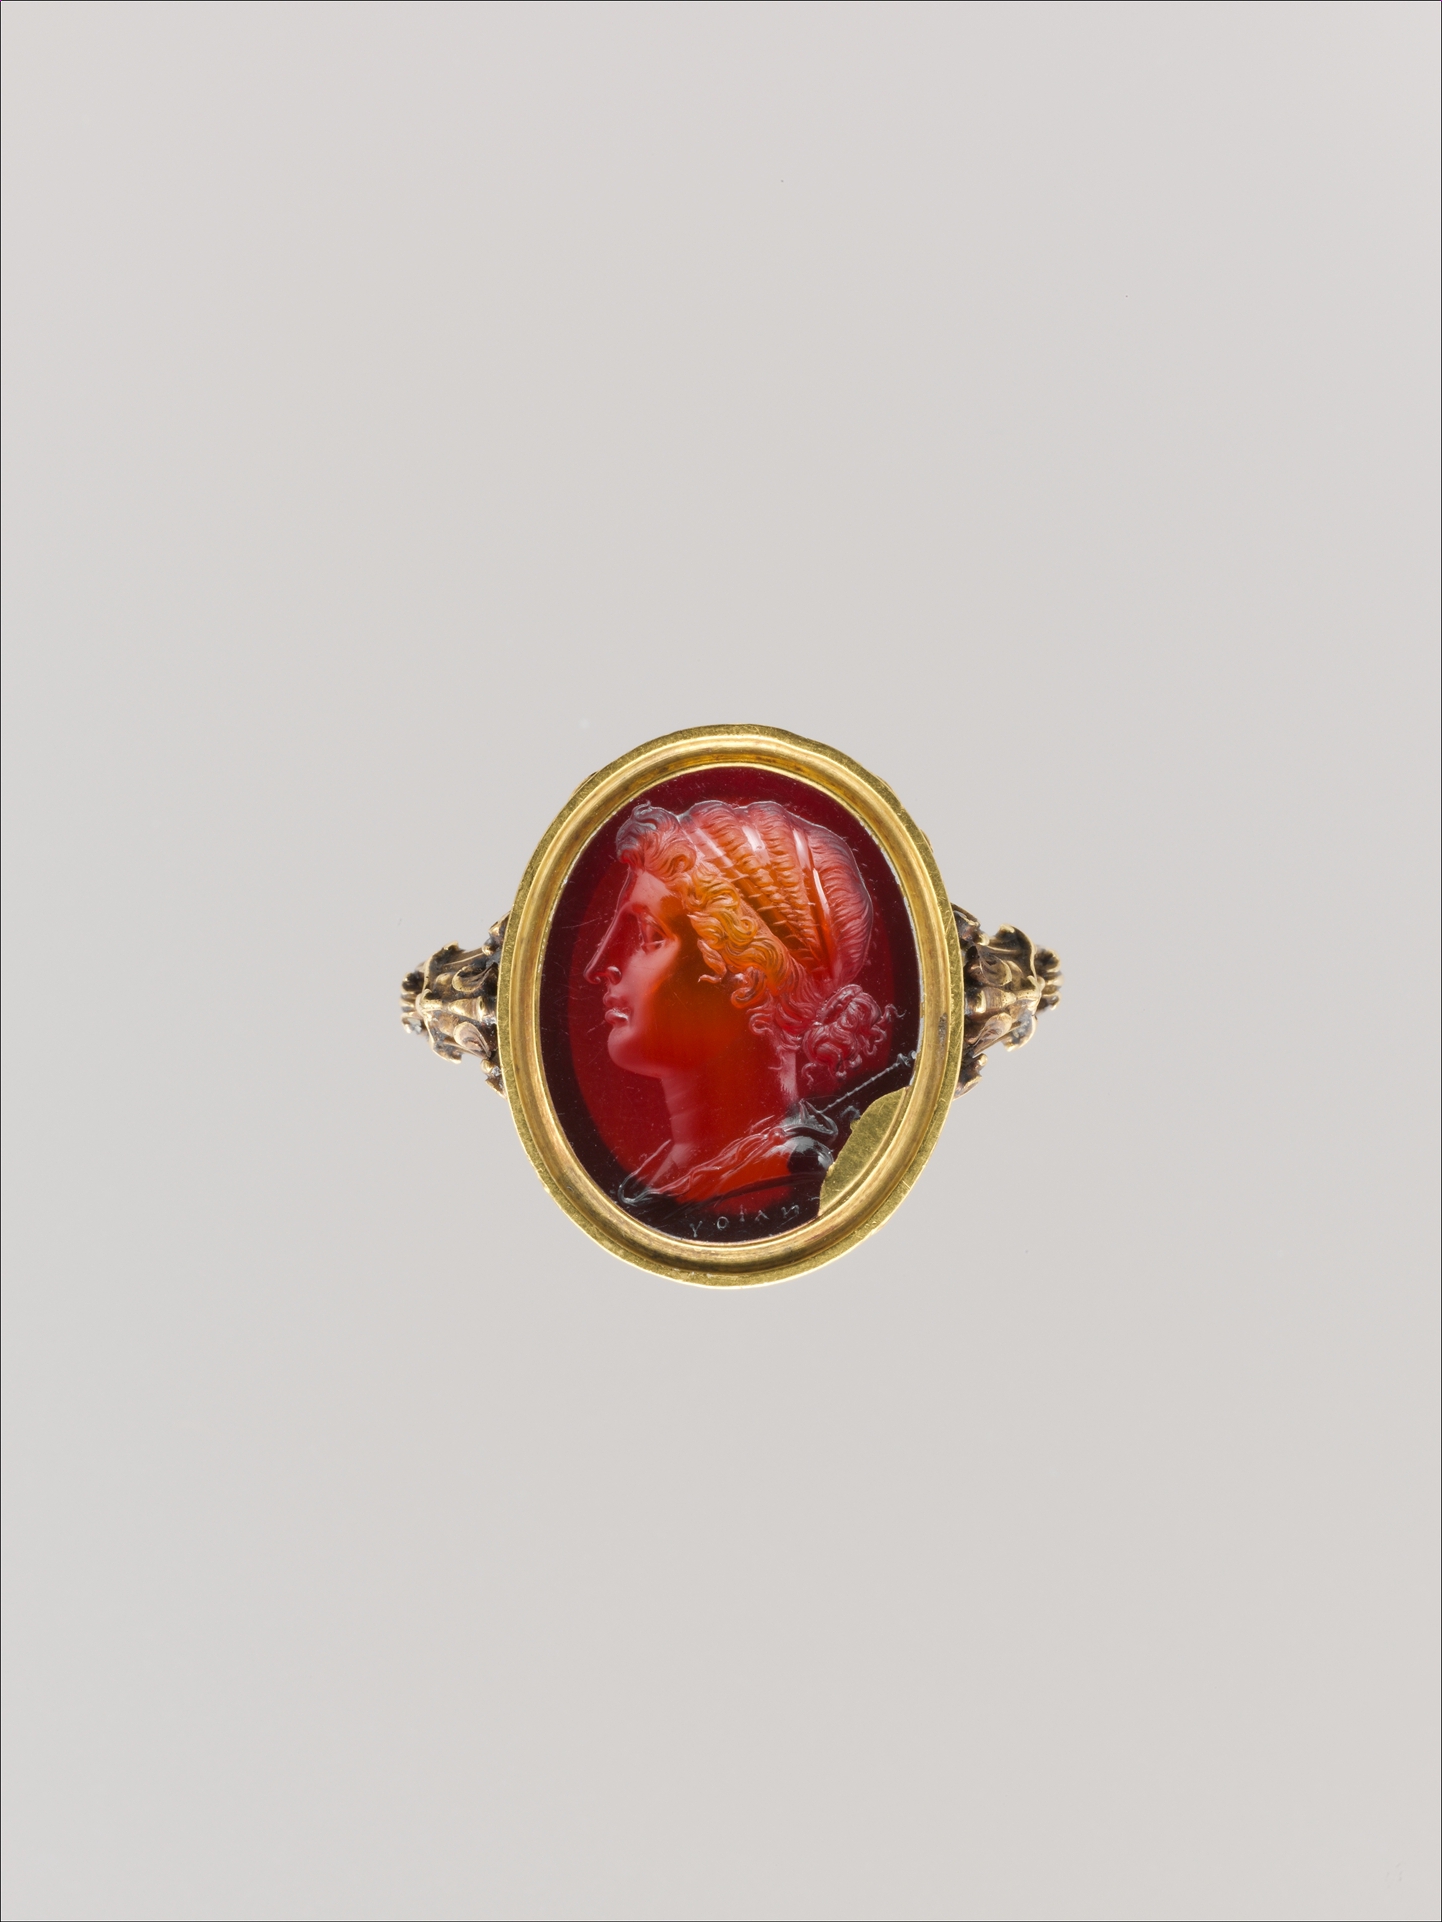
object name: intaglio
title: Carnelian oval set in a 17th–18th century gold ring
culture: roman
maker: gnaios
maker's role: artist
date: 27 BCE-14 CE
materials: gemstone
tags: profiles,women